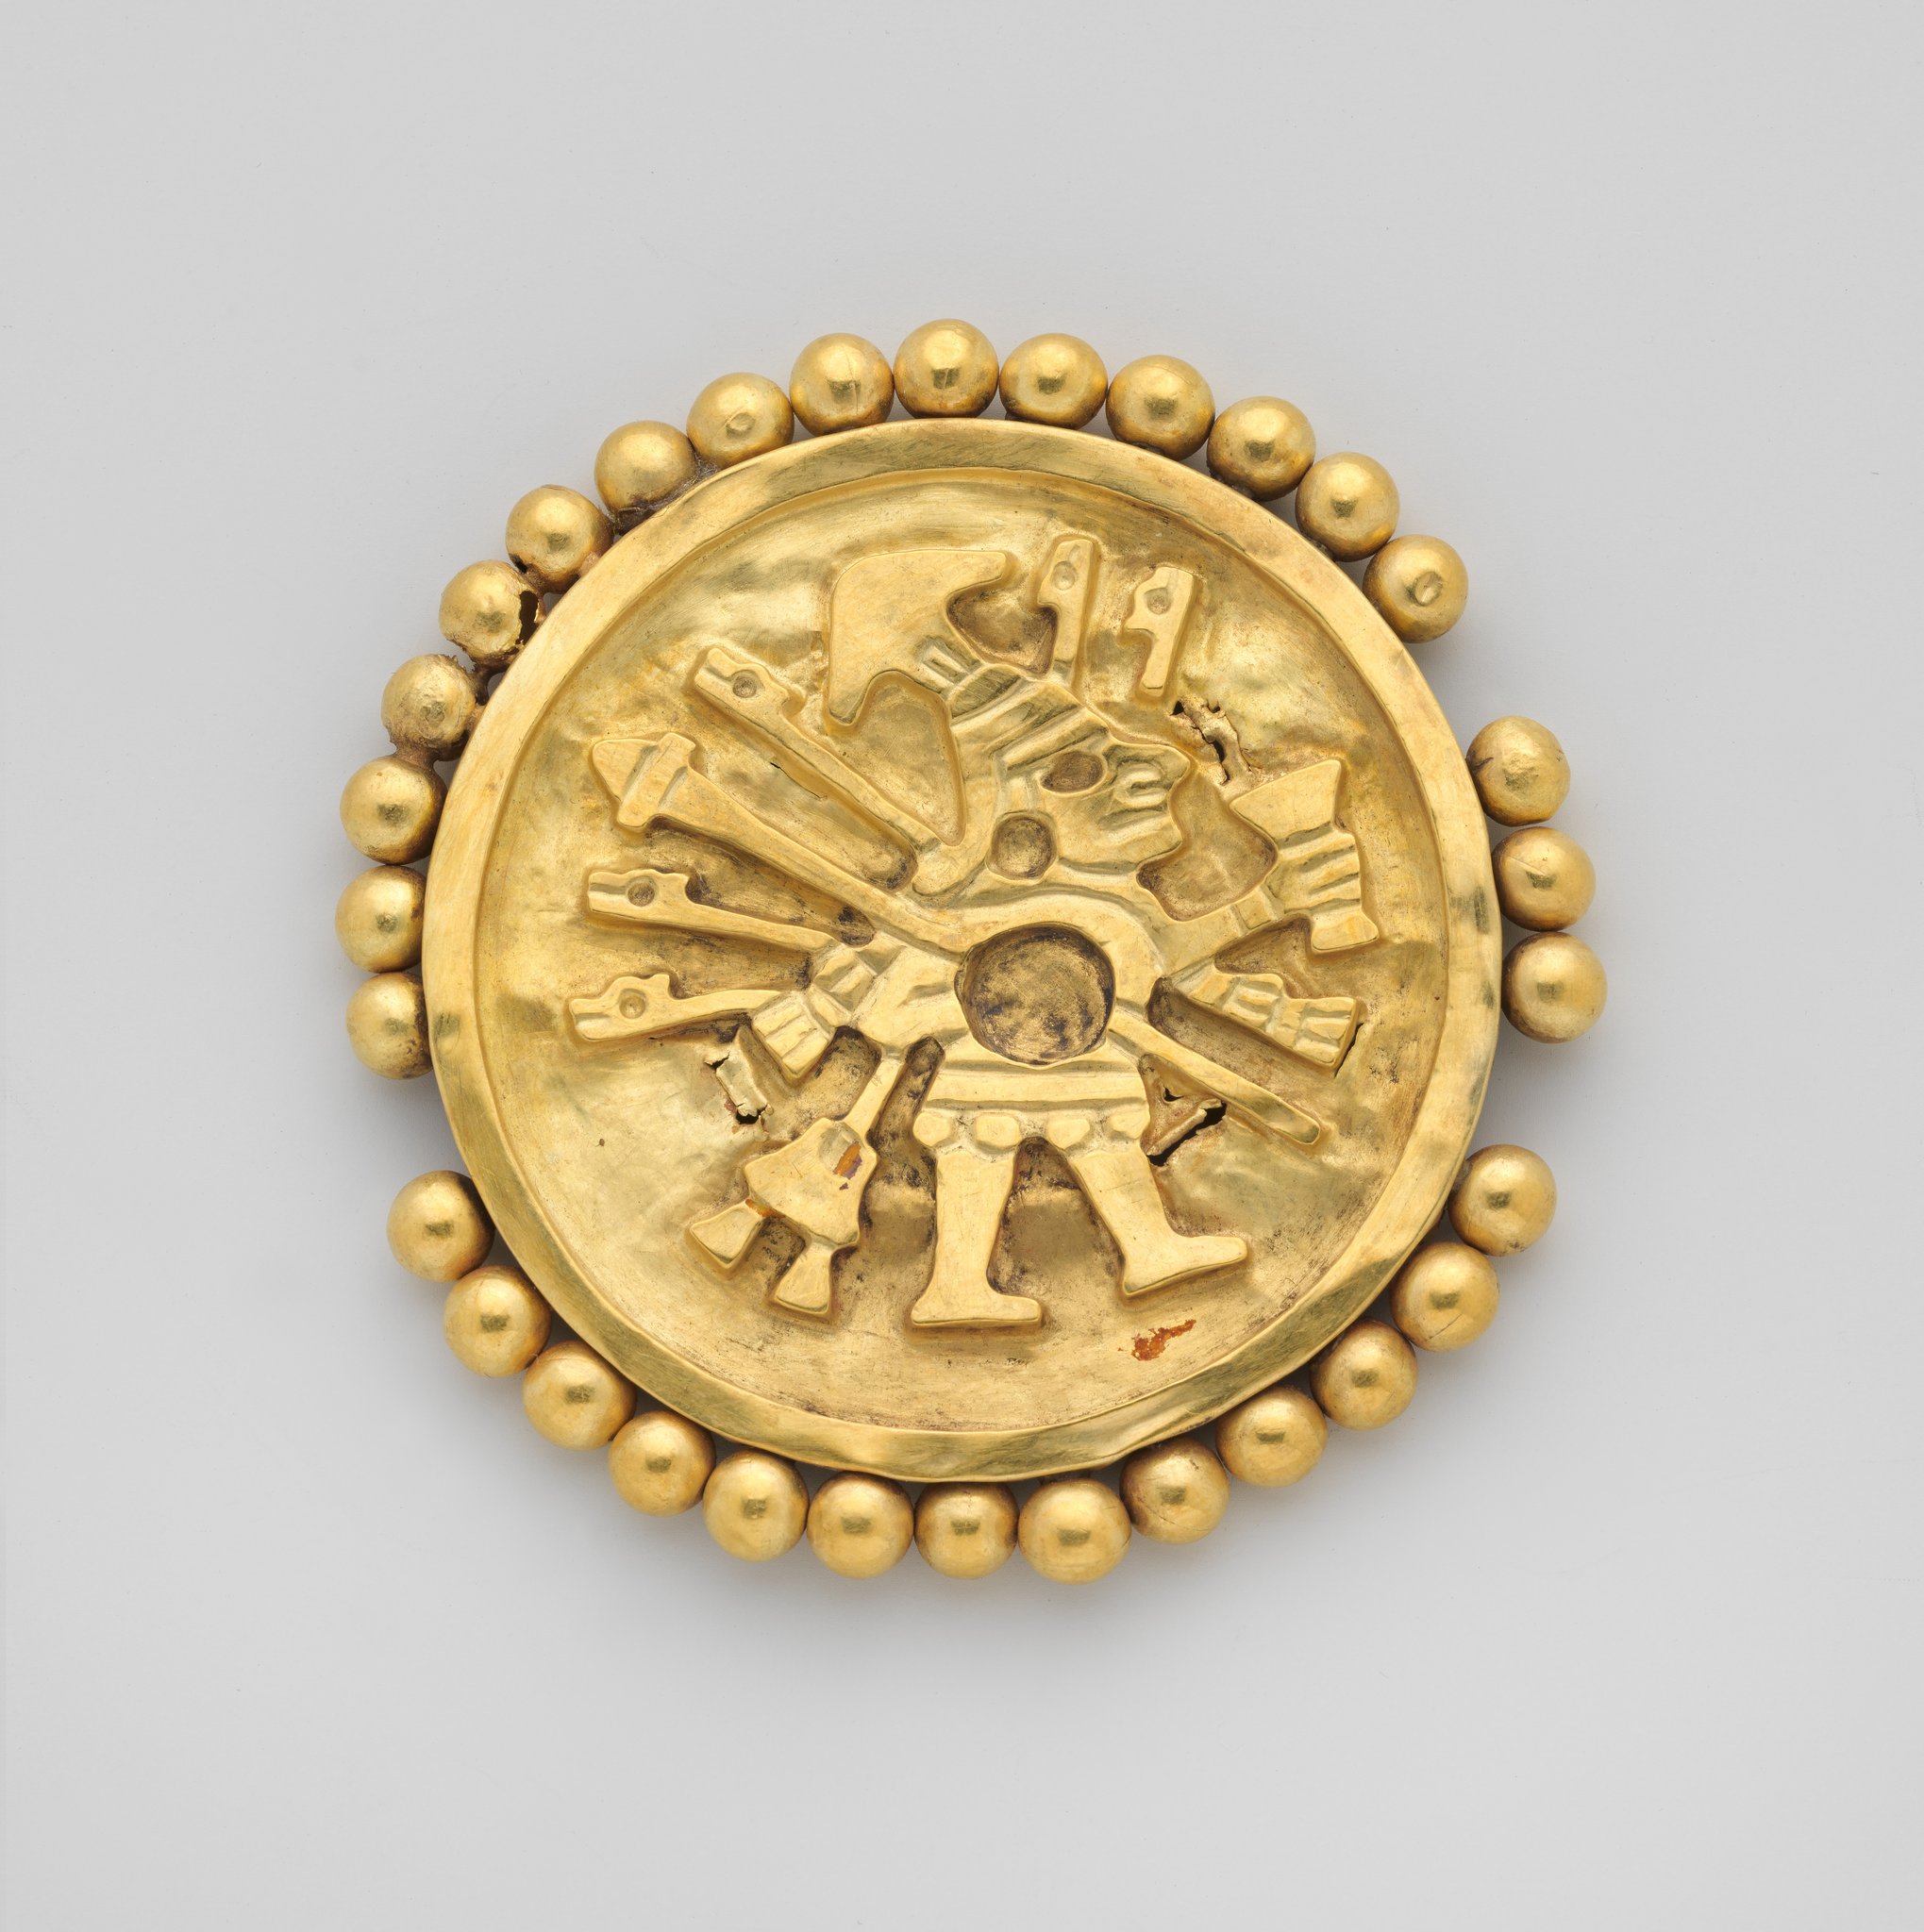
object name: earflare frontal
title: Ear flare frontal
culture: moche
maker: moche artist(s)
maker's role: artist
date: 200-600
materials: gold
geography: peru